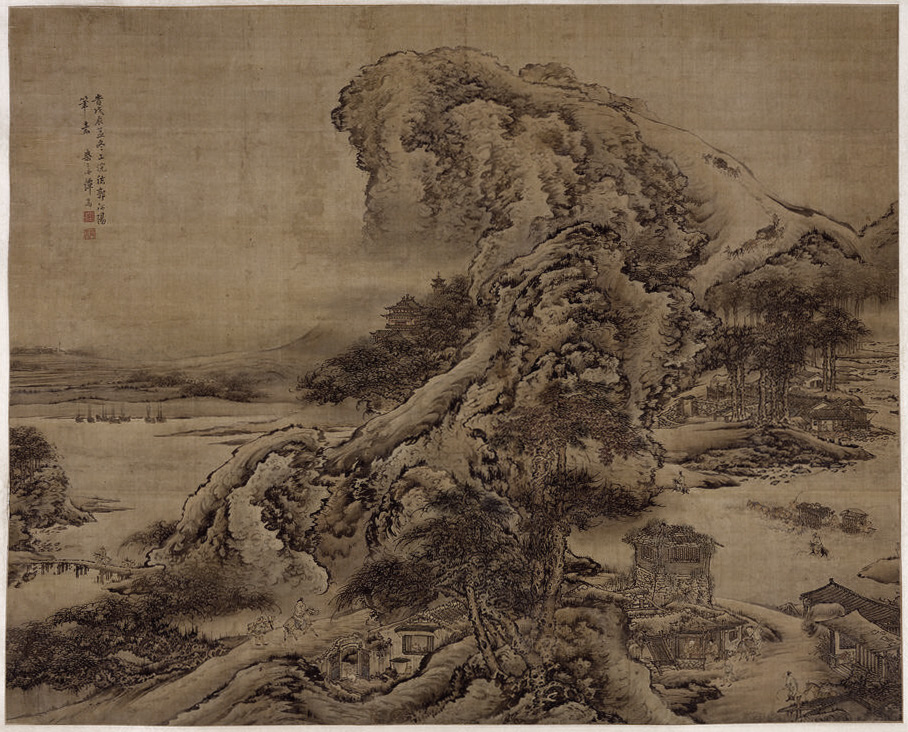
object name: hanging scroll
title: Landscape in the Style of Guo Xi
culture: chinese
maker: tan song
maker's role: artist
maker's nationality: chinese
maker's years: 1700-1800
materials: ink, silk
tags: landscapes